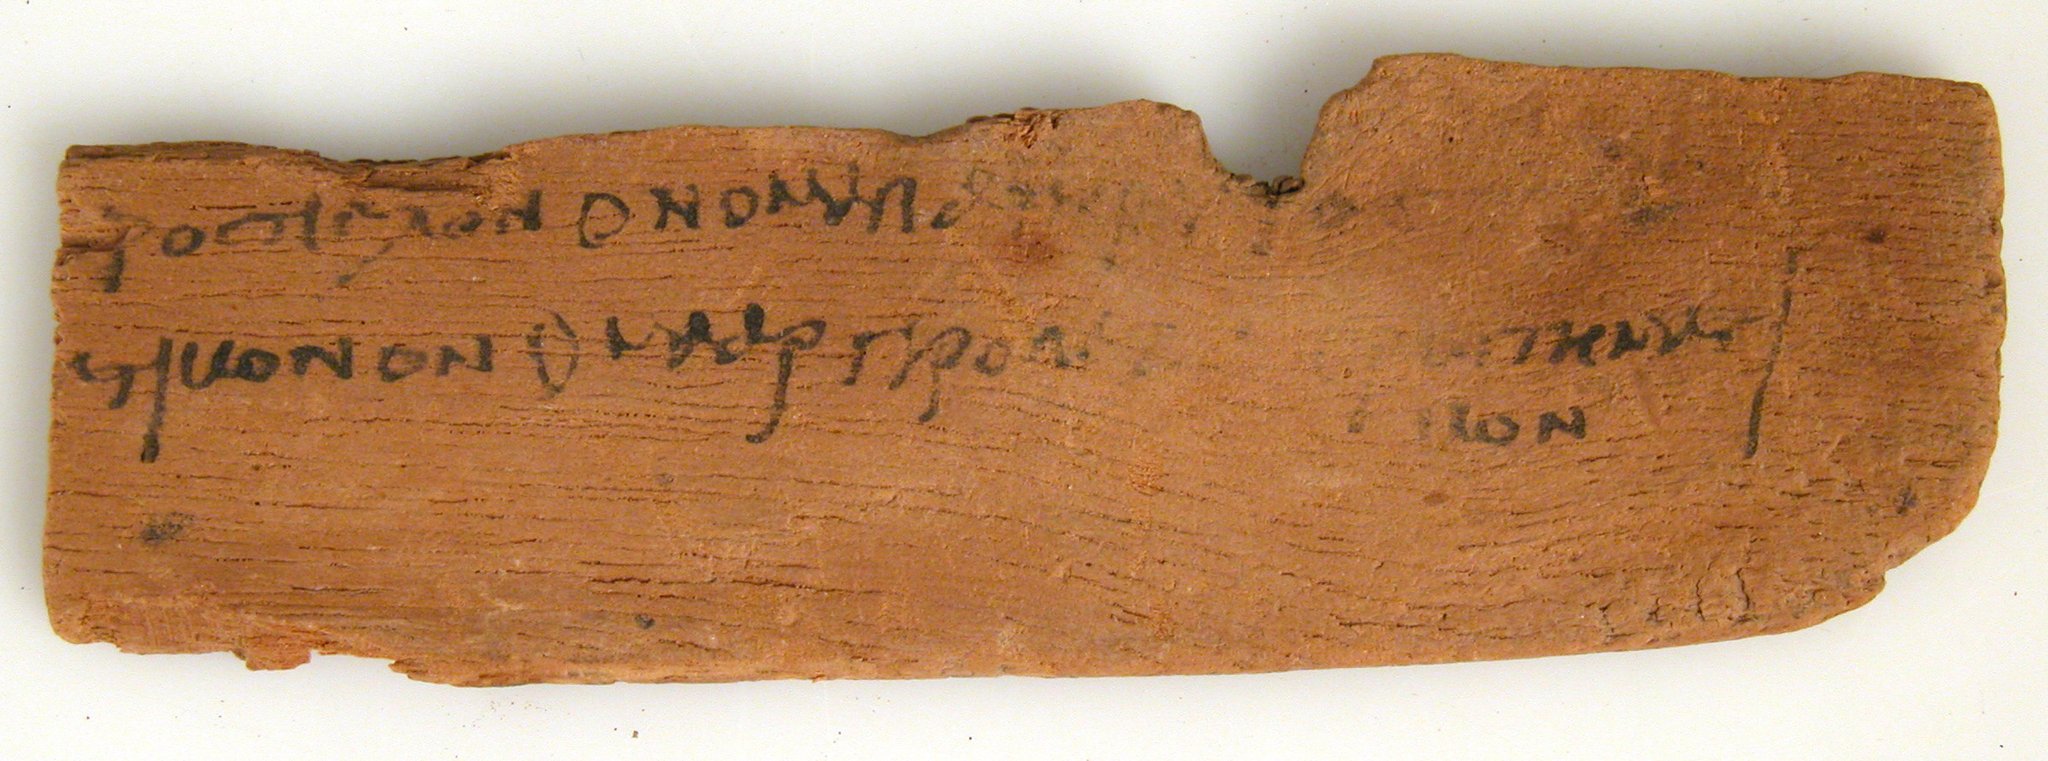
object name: ostrakon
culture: coptic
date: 301-700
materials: ink, wood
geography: egypt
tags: documents